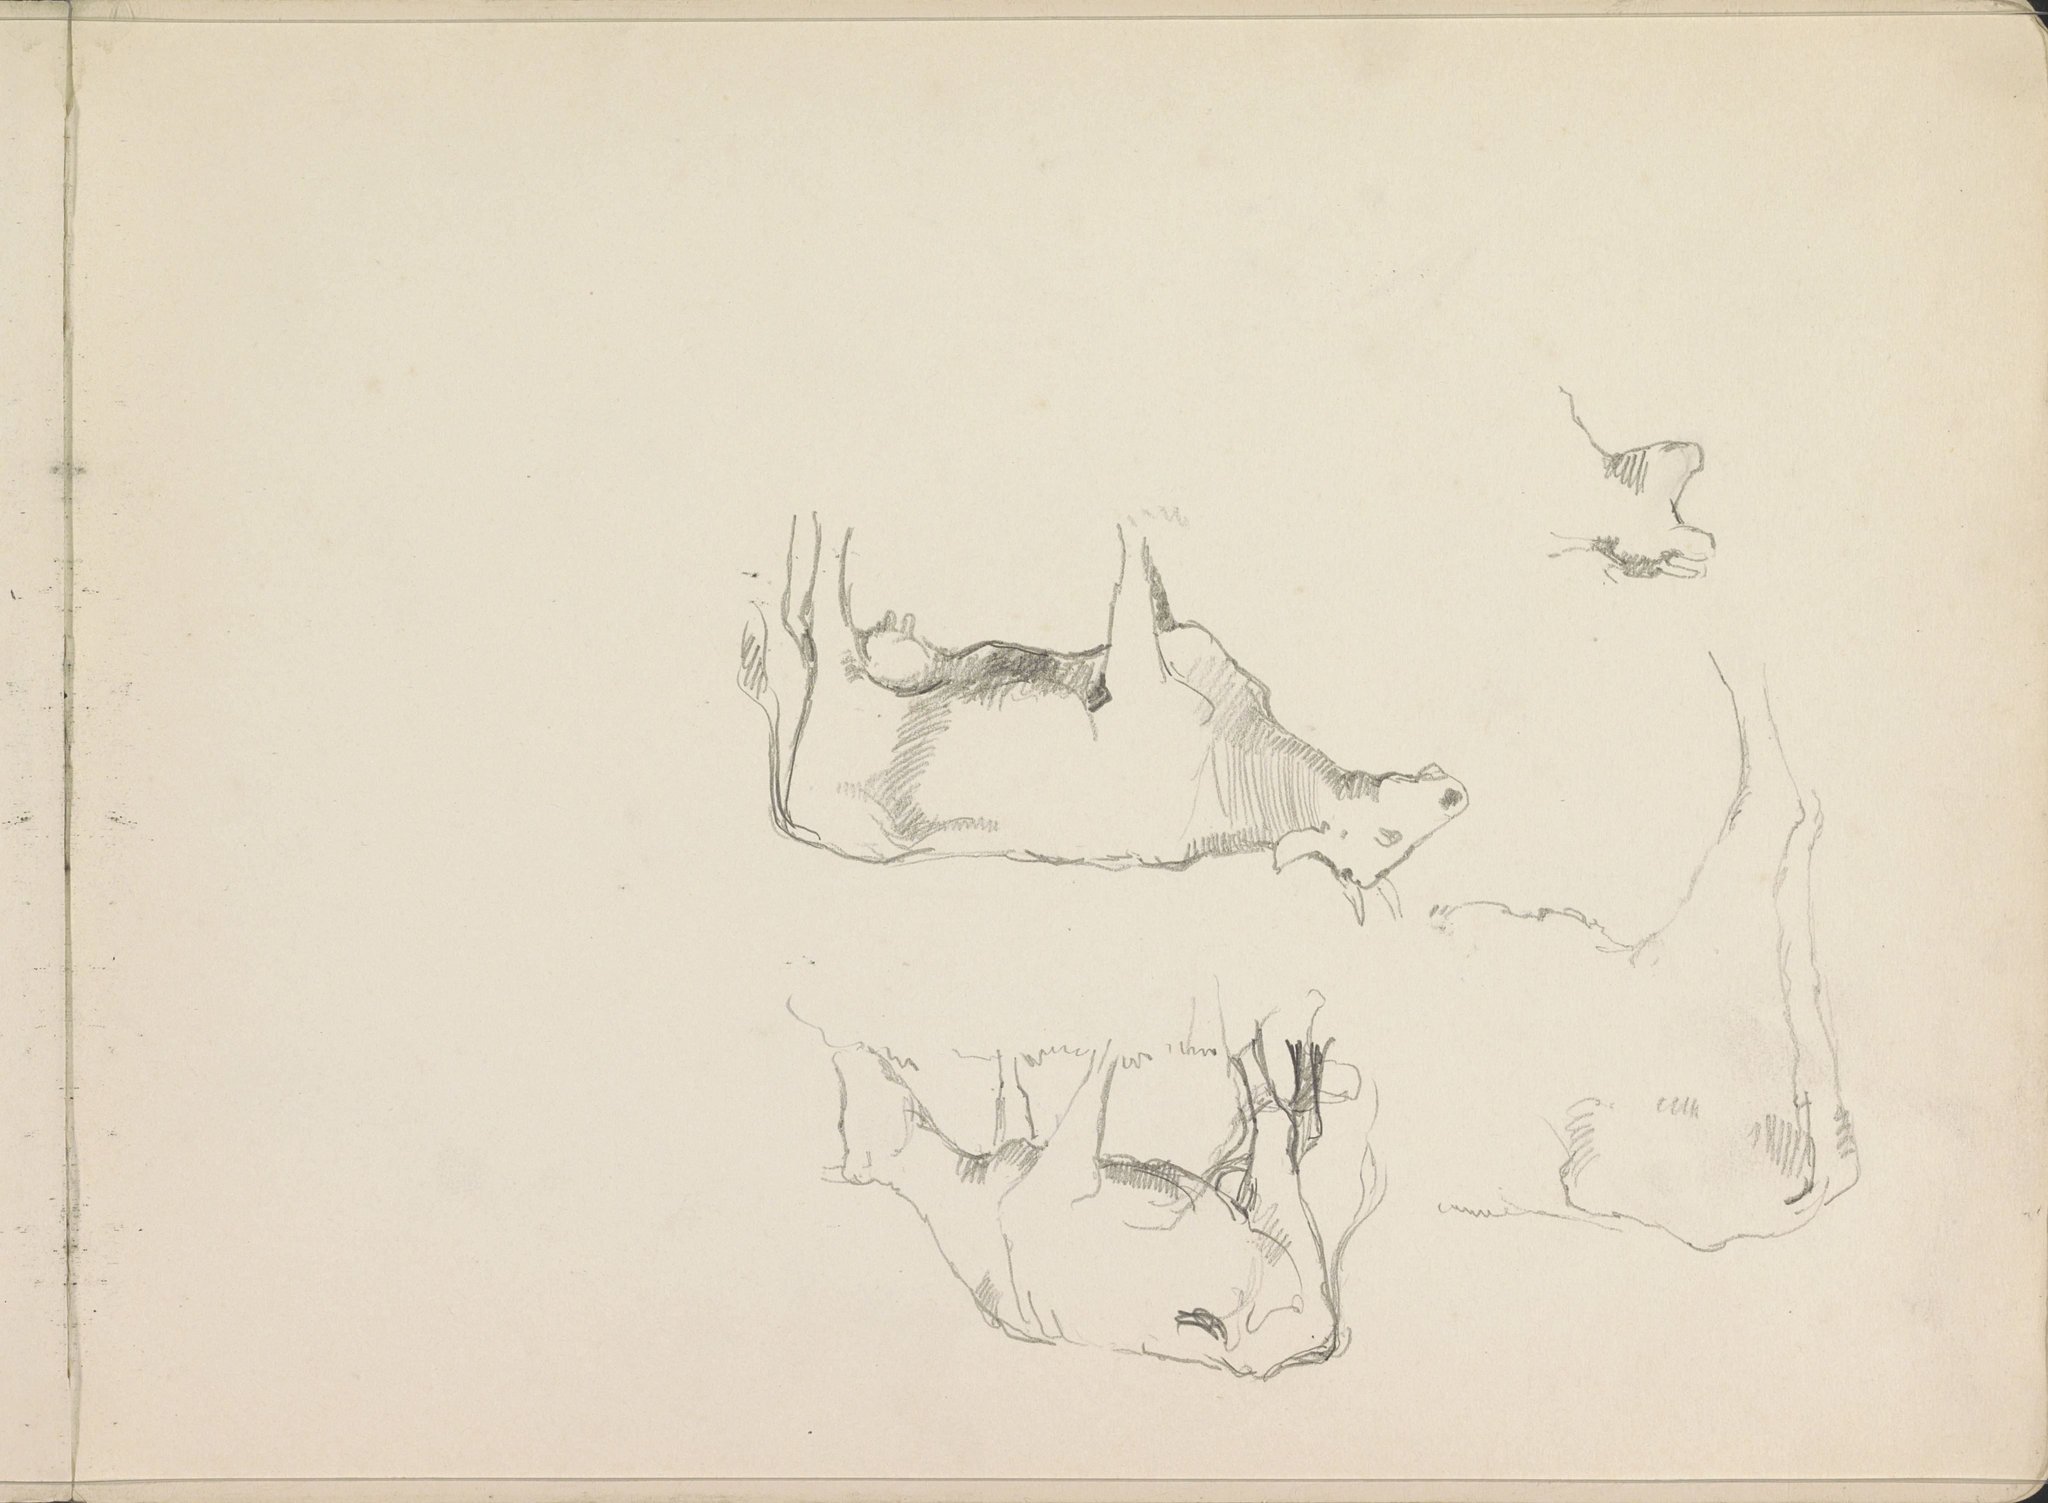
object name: sketchbook leaf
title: Koeien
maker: cornelis vreedenburgh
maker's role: draughtsman, print maker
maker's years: 1880-1946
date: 1890-1946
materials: paper, pencil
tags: cow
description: Blad 5 recto uit een schetsboek met 23 bladen.